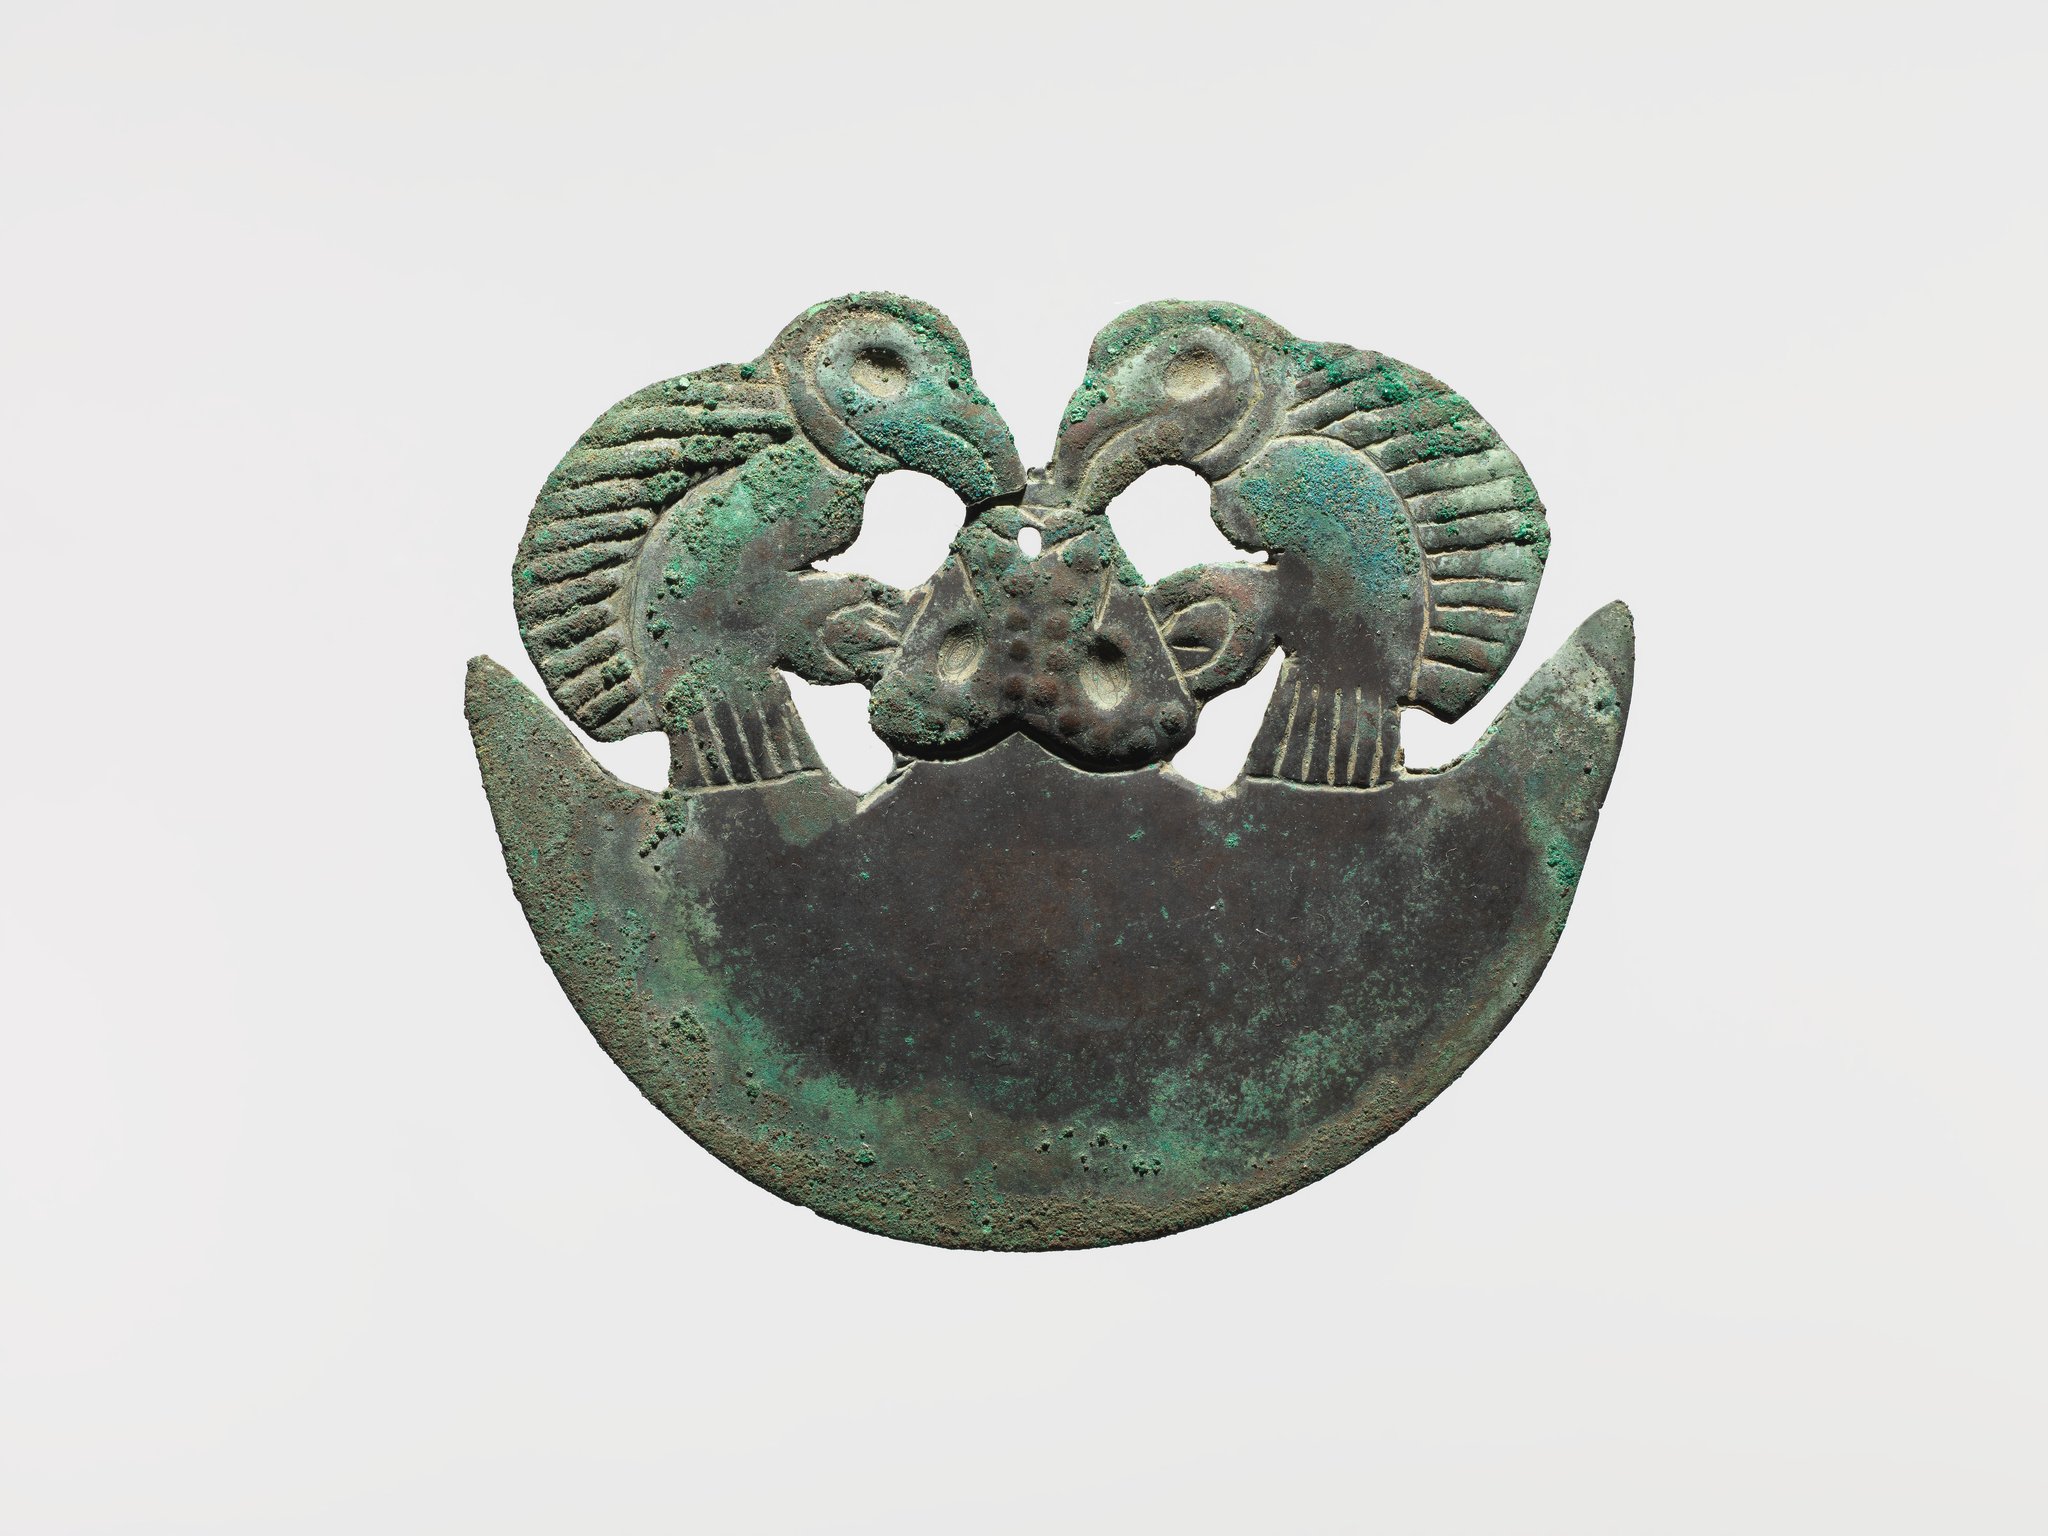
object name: ornament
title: Crescent Ornament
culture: moche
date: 201-300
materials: copper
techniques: hammering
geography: peru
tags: birds